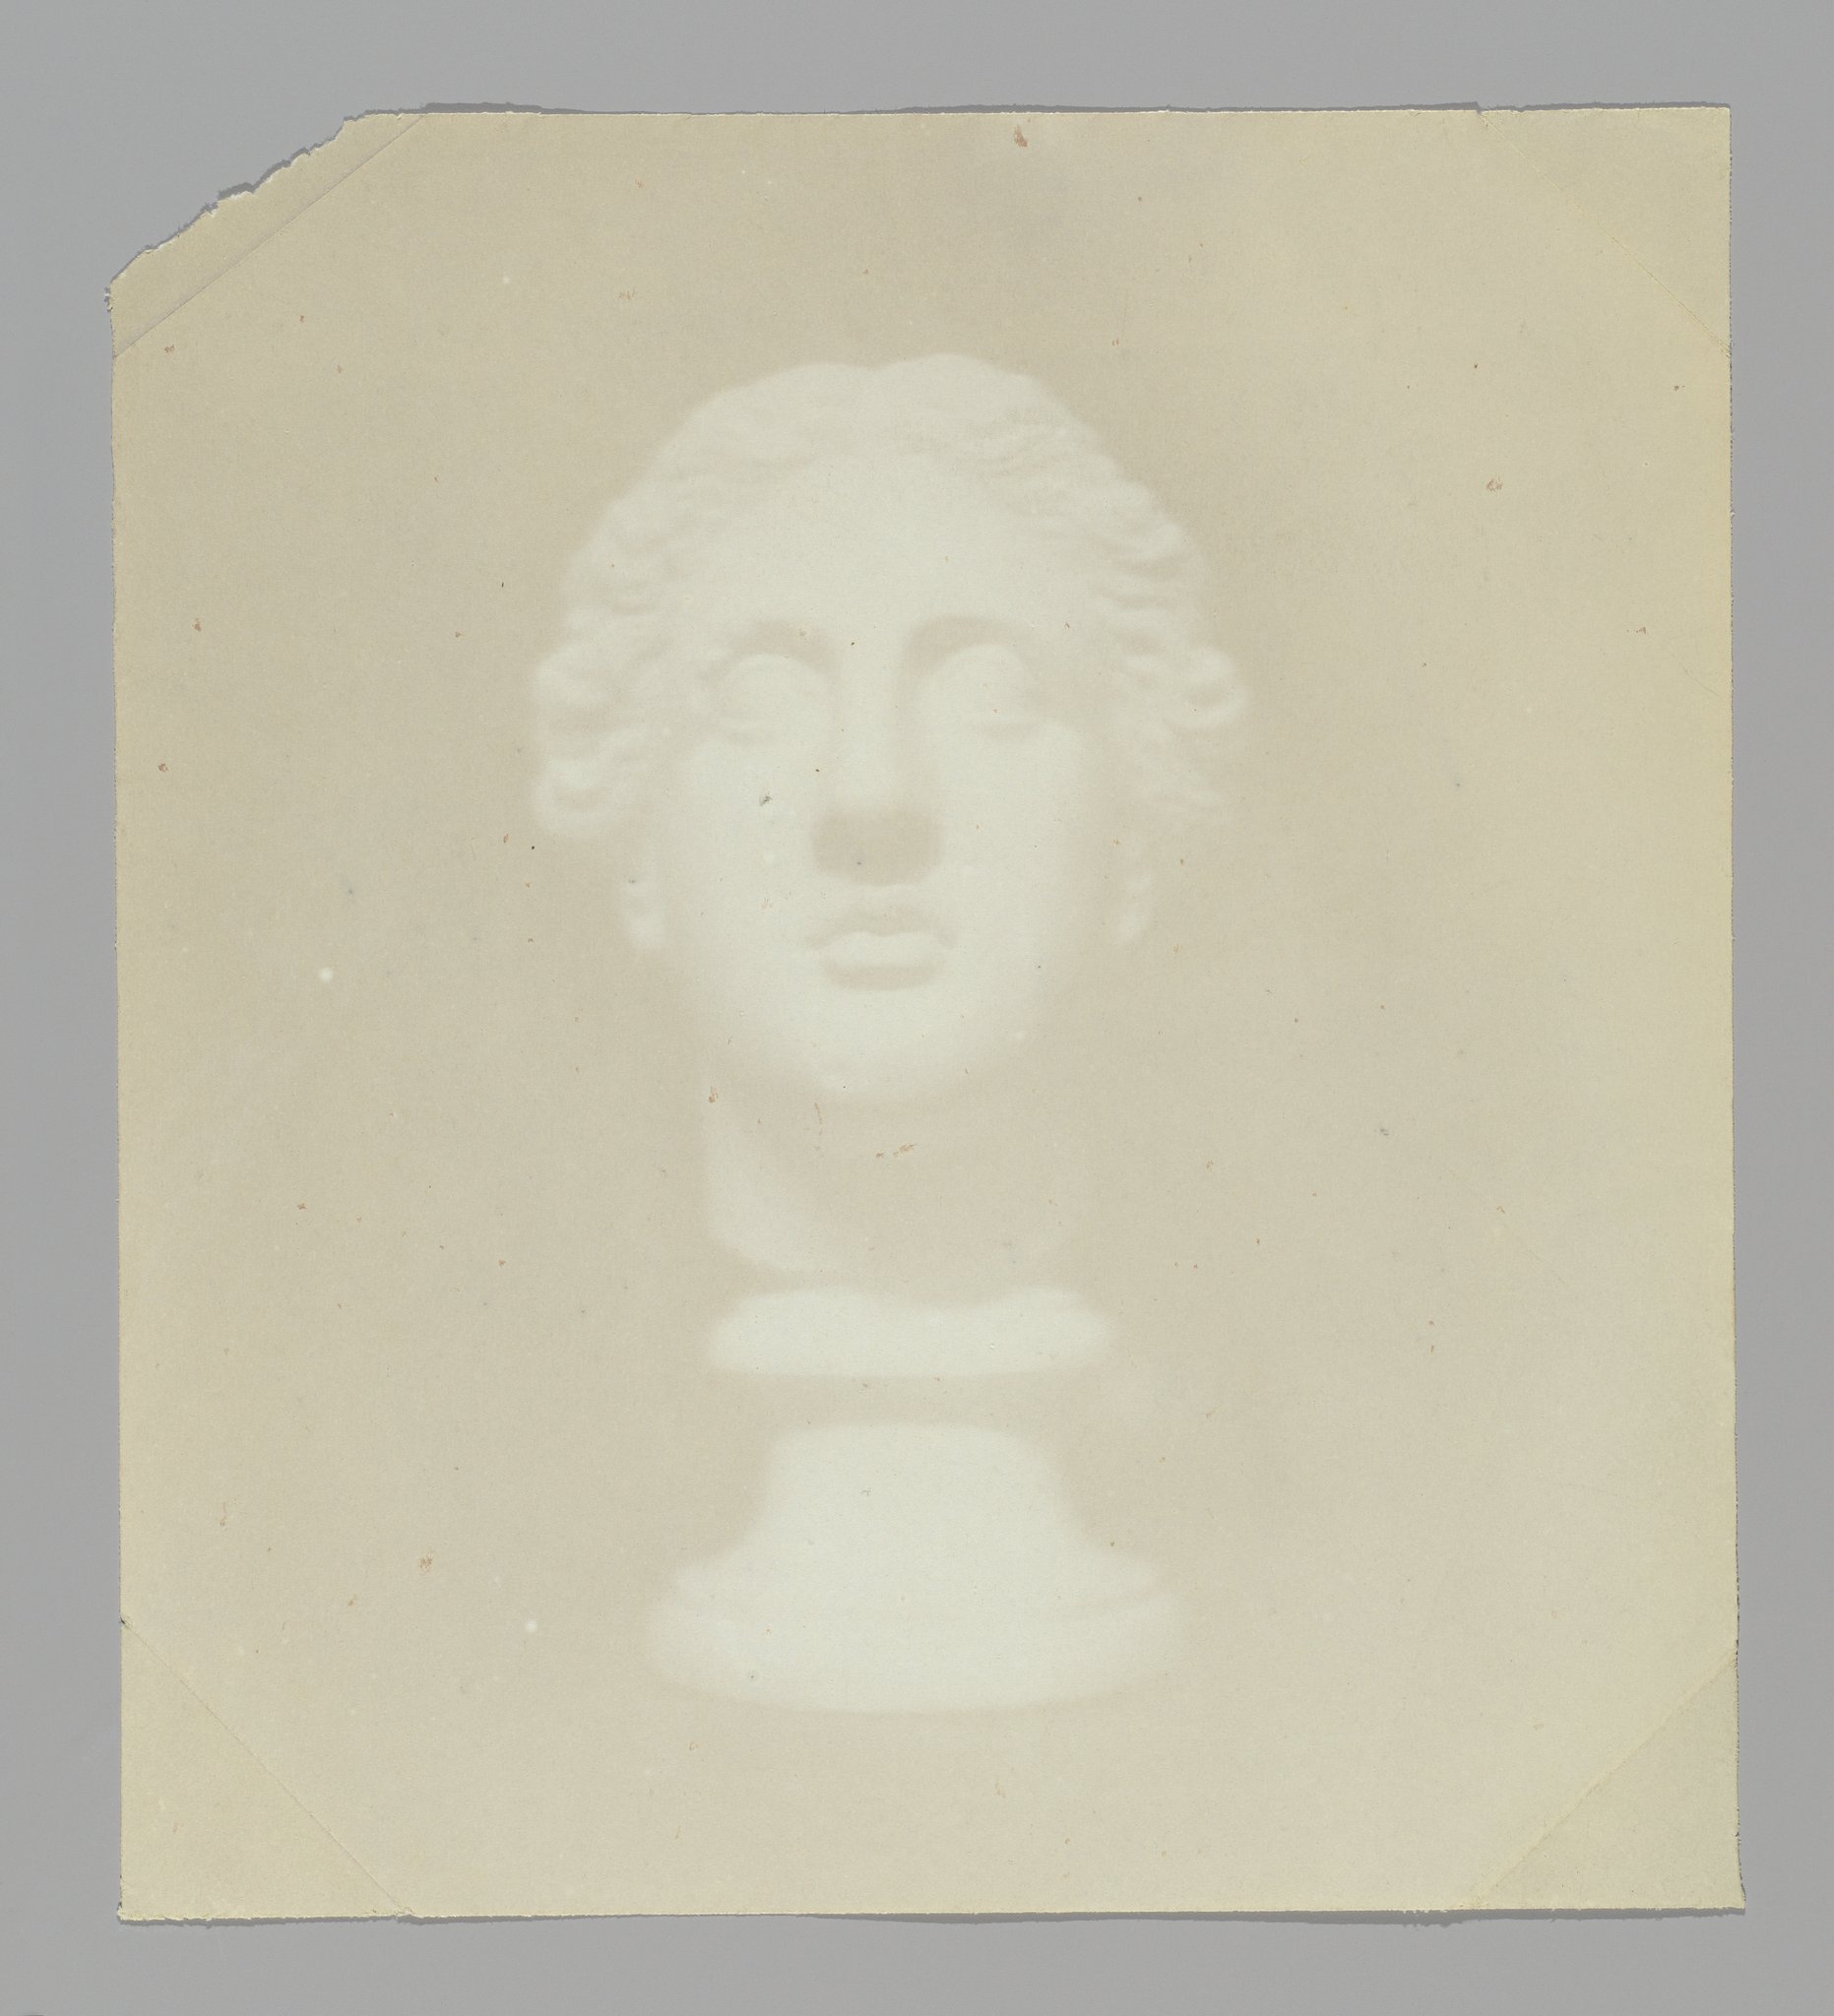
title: [Classical Head]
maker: hippolyte bayard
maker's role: artist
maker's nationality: french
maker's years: 1801-1887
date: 1839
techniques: salted paper print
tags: sculpture,heads